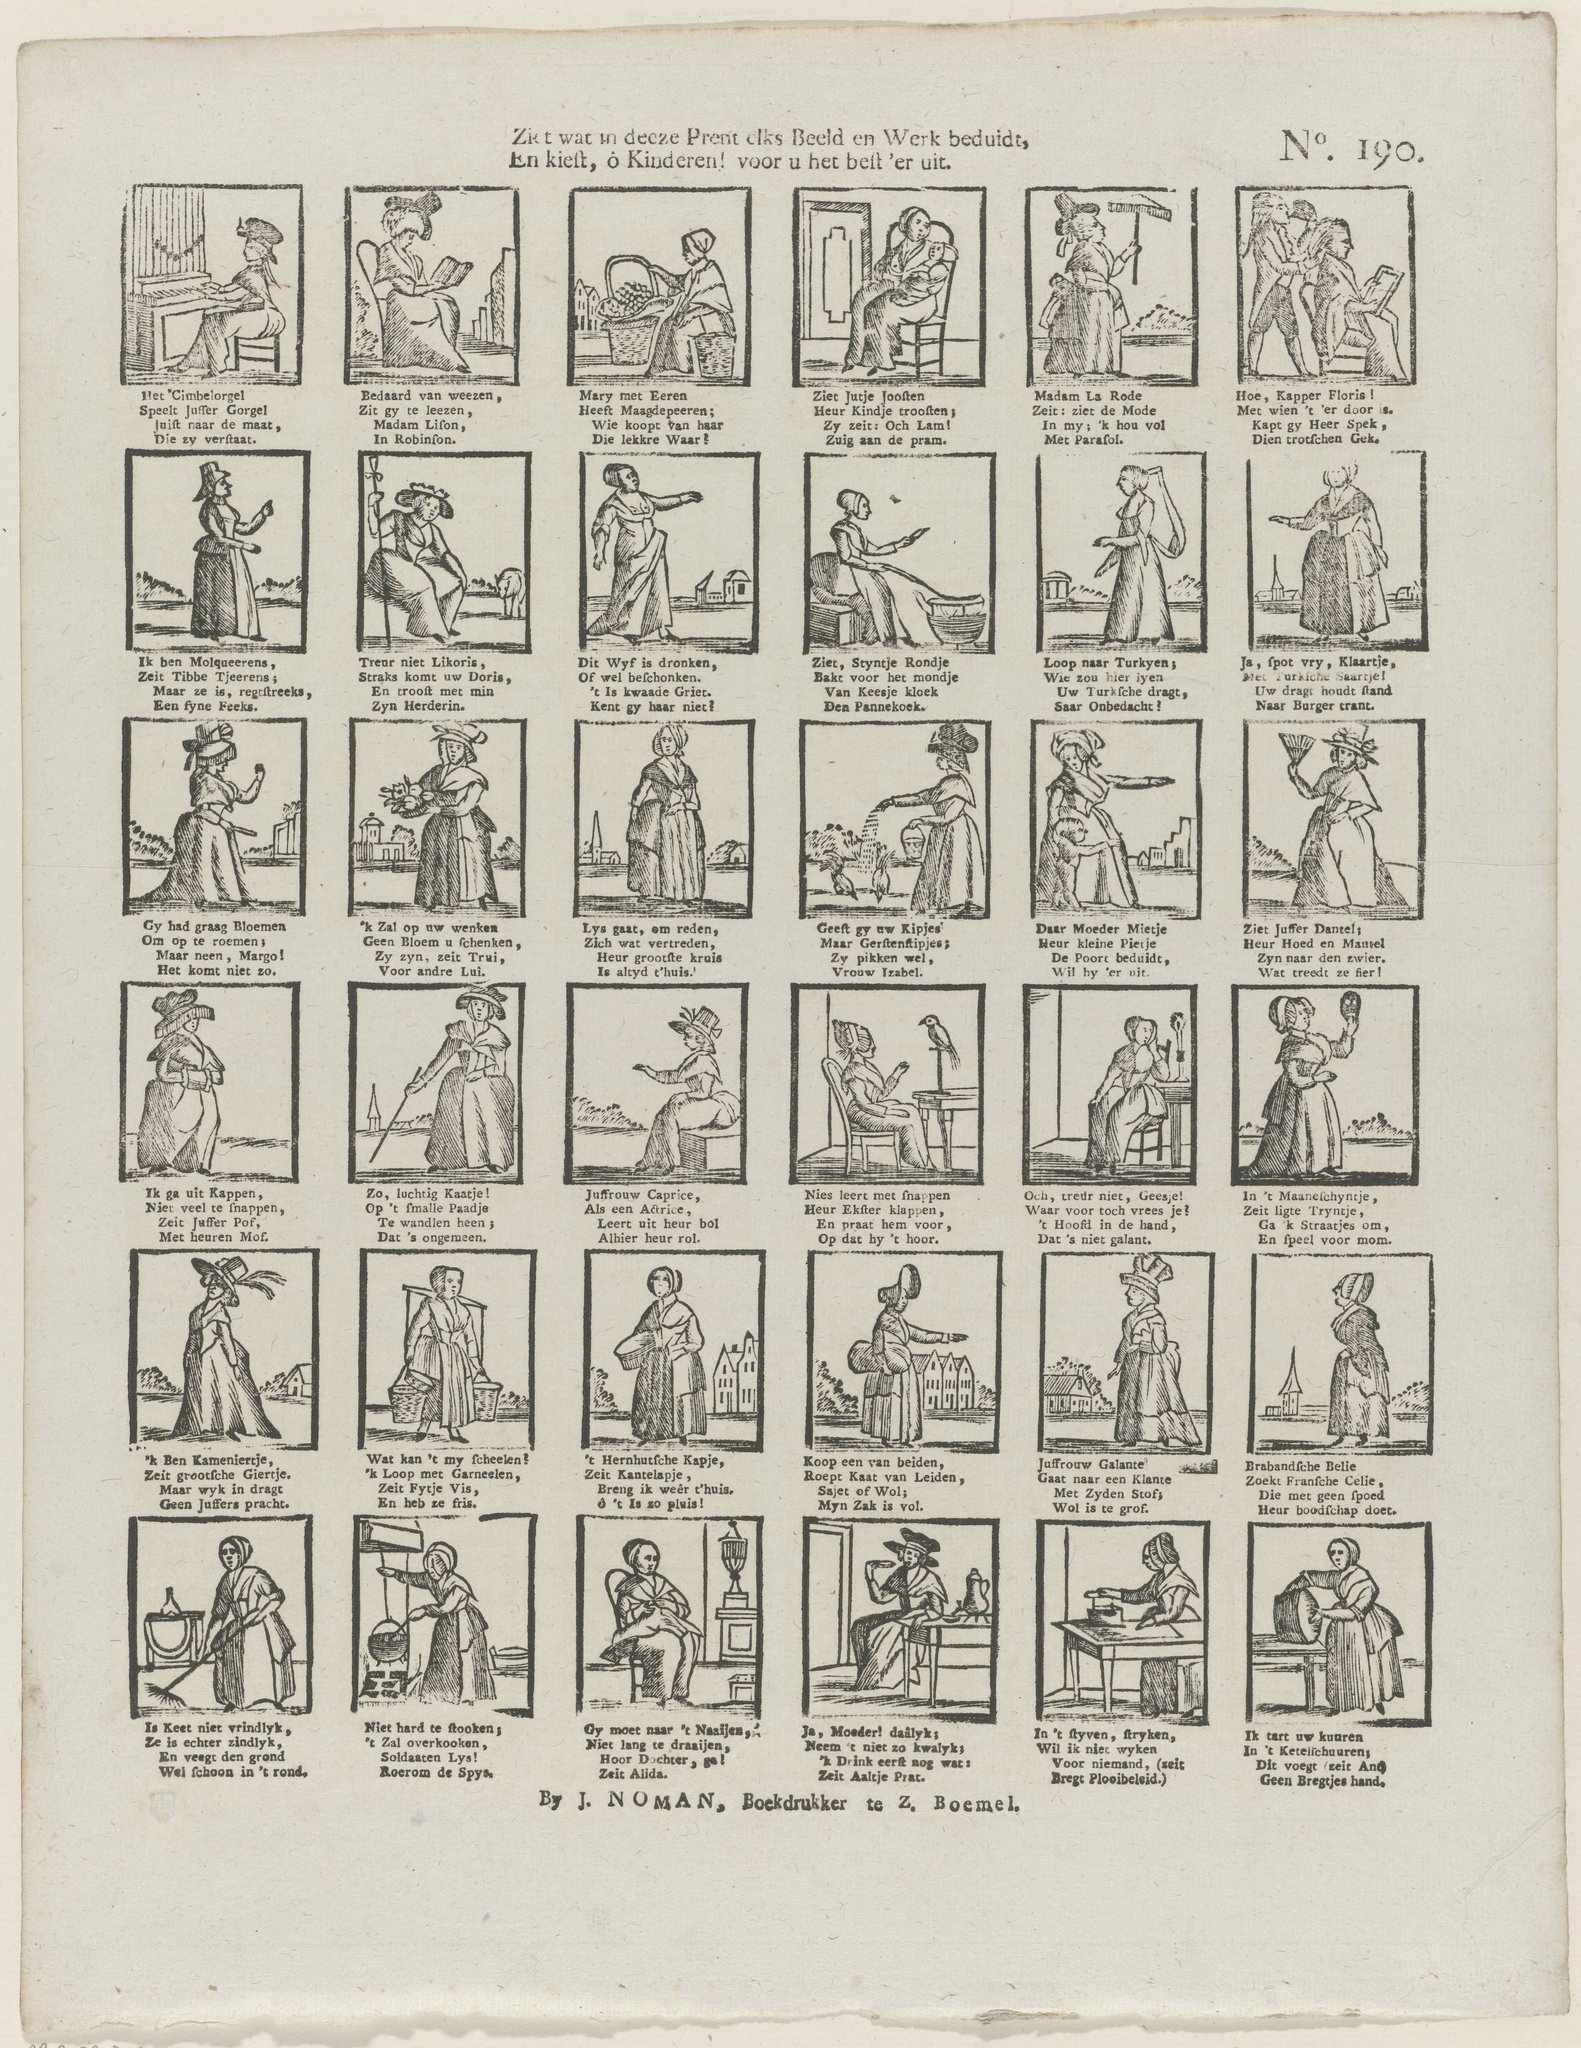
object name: popular print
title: Ziet wat in deeze prent elks beeld en werk beduidt, / En kiest, ô kinderen! voor u het best 'er uit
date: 1806-1830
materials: paper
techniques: letterpress printing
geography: zaltbommel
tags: adult woman, herding, herdsman, herdswoman, shepherd, shepherdess, cowherd, etc., household chores, milkmaid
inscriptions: collector's mark: Lugt 2760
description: Blad met 36 voorstellingen van beroepen en bezigheden voor vrouwen. Onder elke afbeelding een vierregelig vers. Genummerd rechtsboven: No. 190.